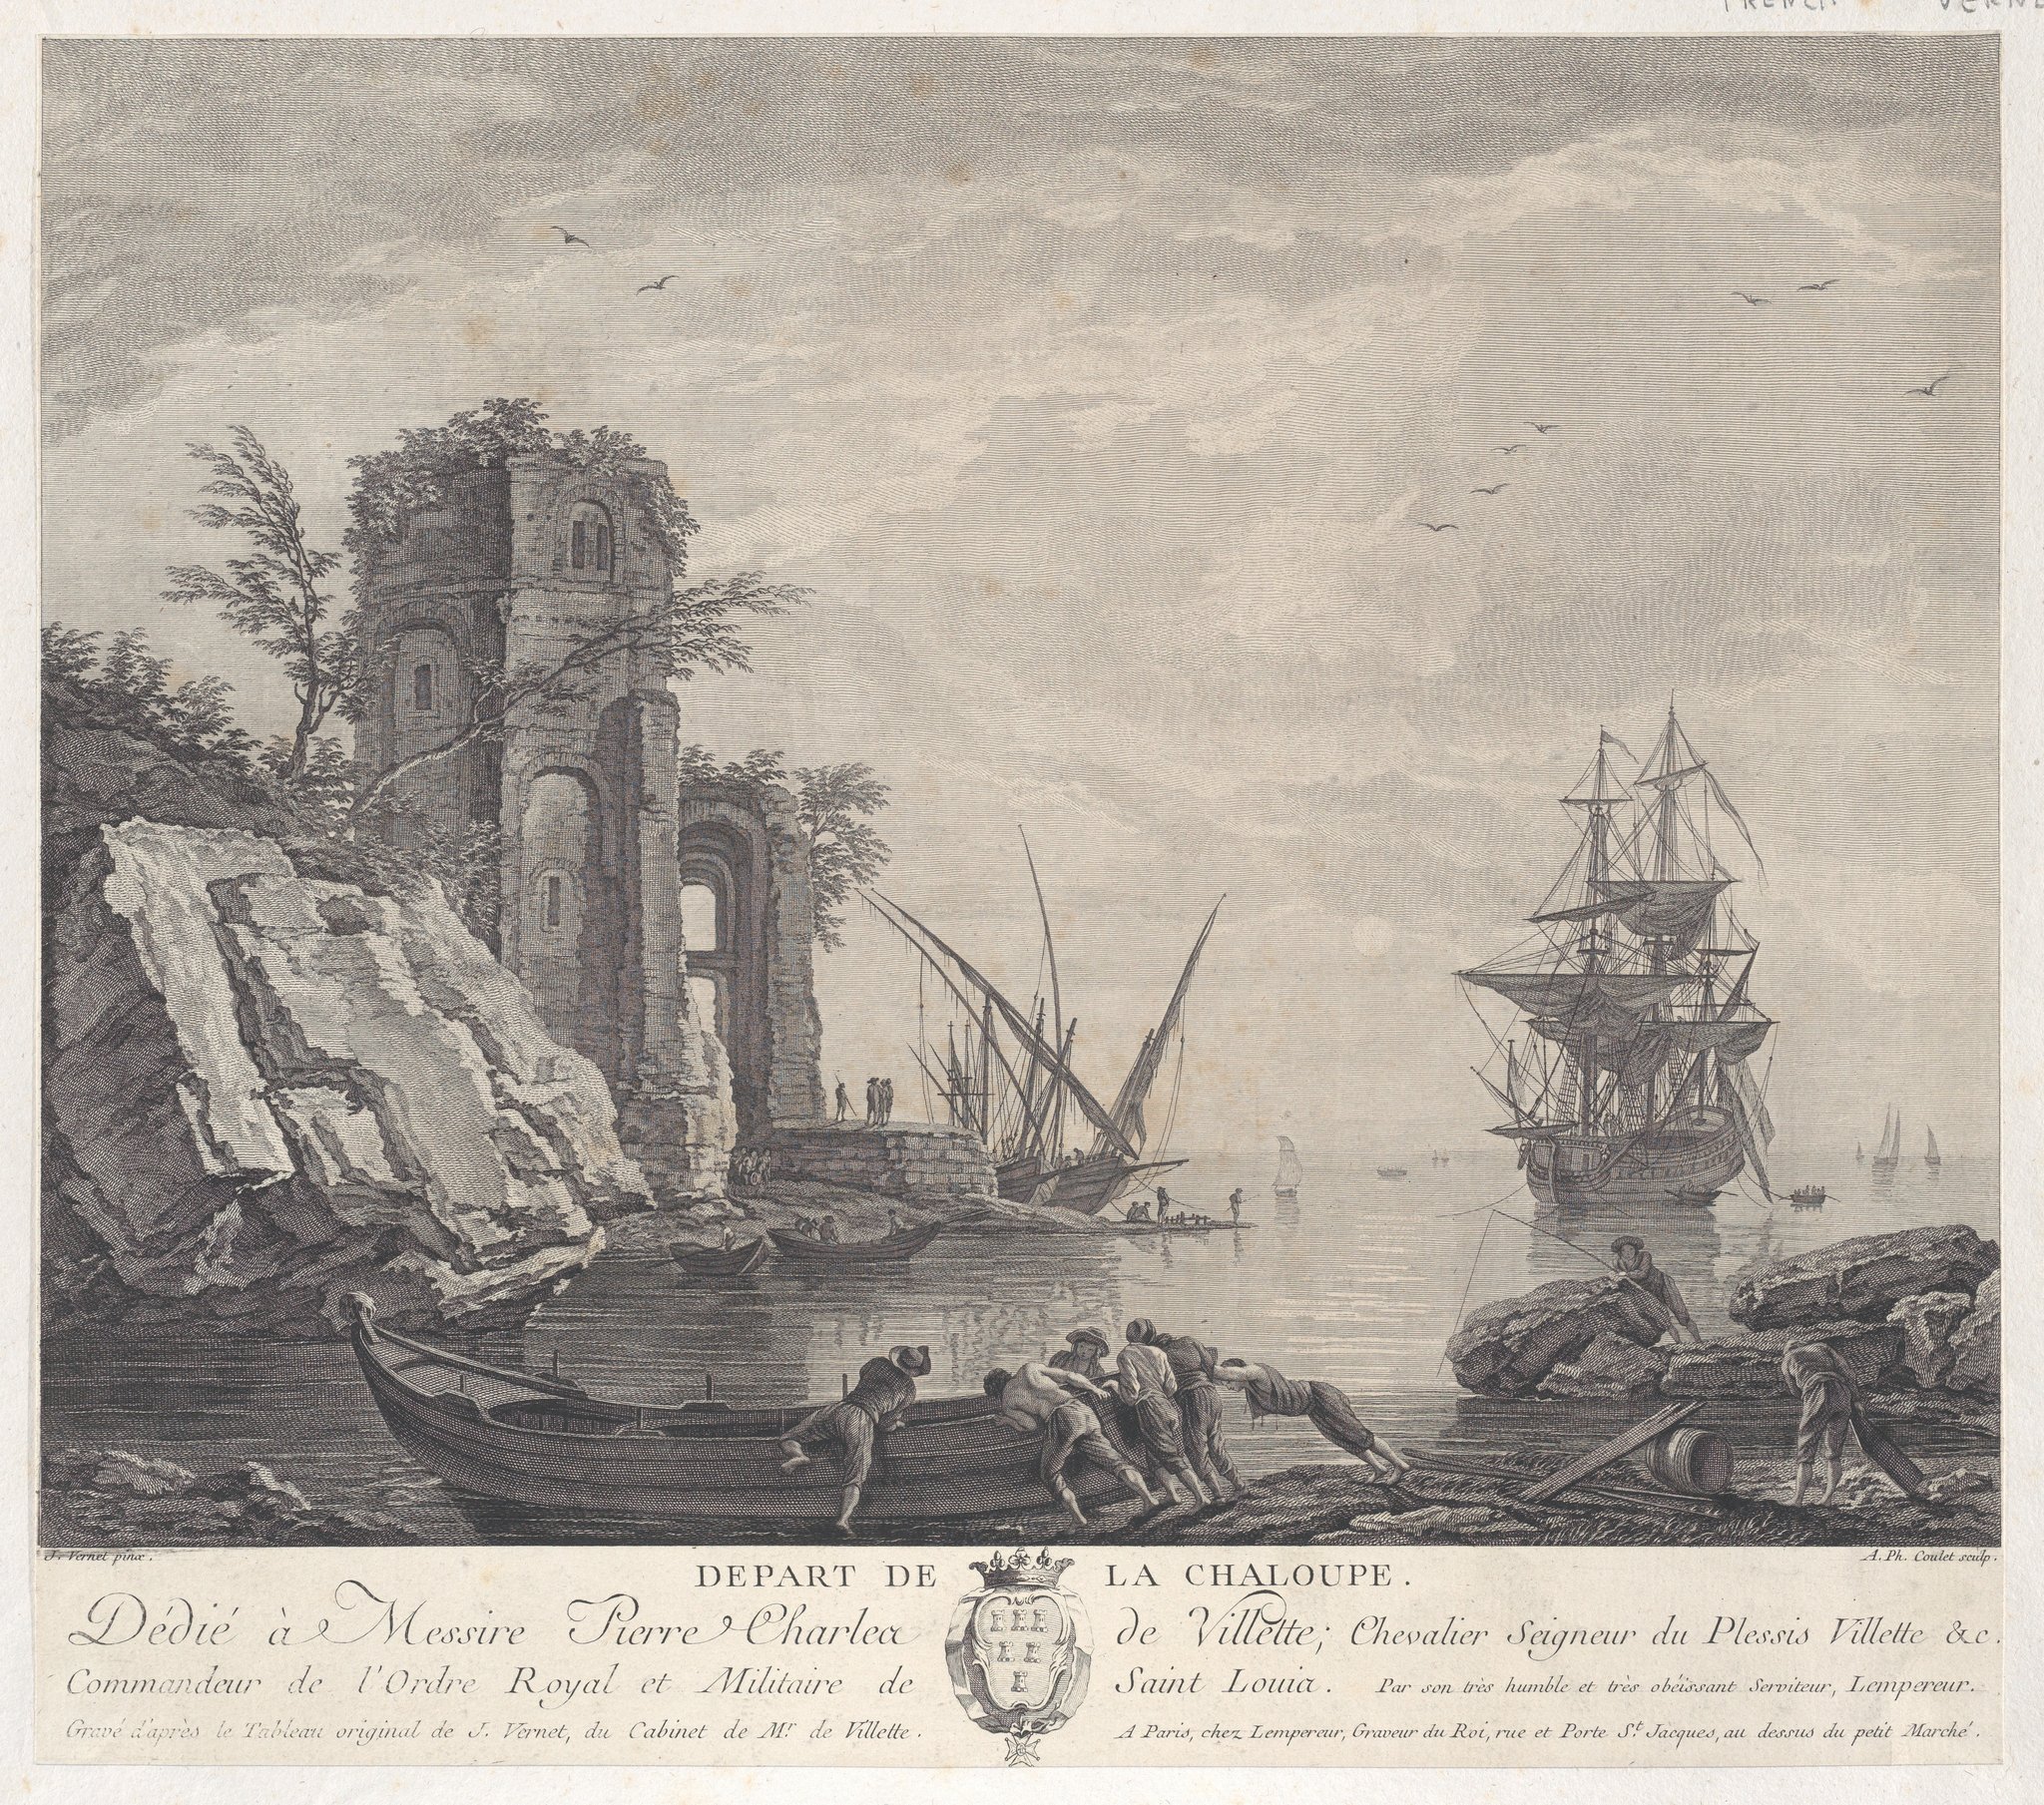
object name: print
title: Departure of the Ship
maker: joseph vernet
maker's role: artist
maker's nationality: french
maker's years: 1714-1789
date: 1770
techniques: engraving